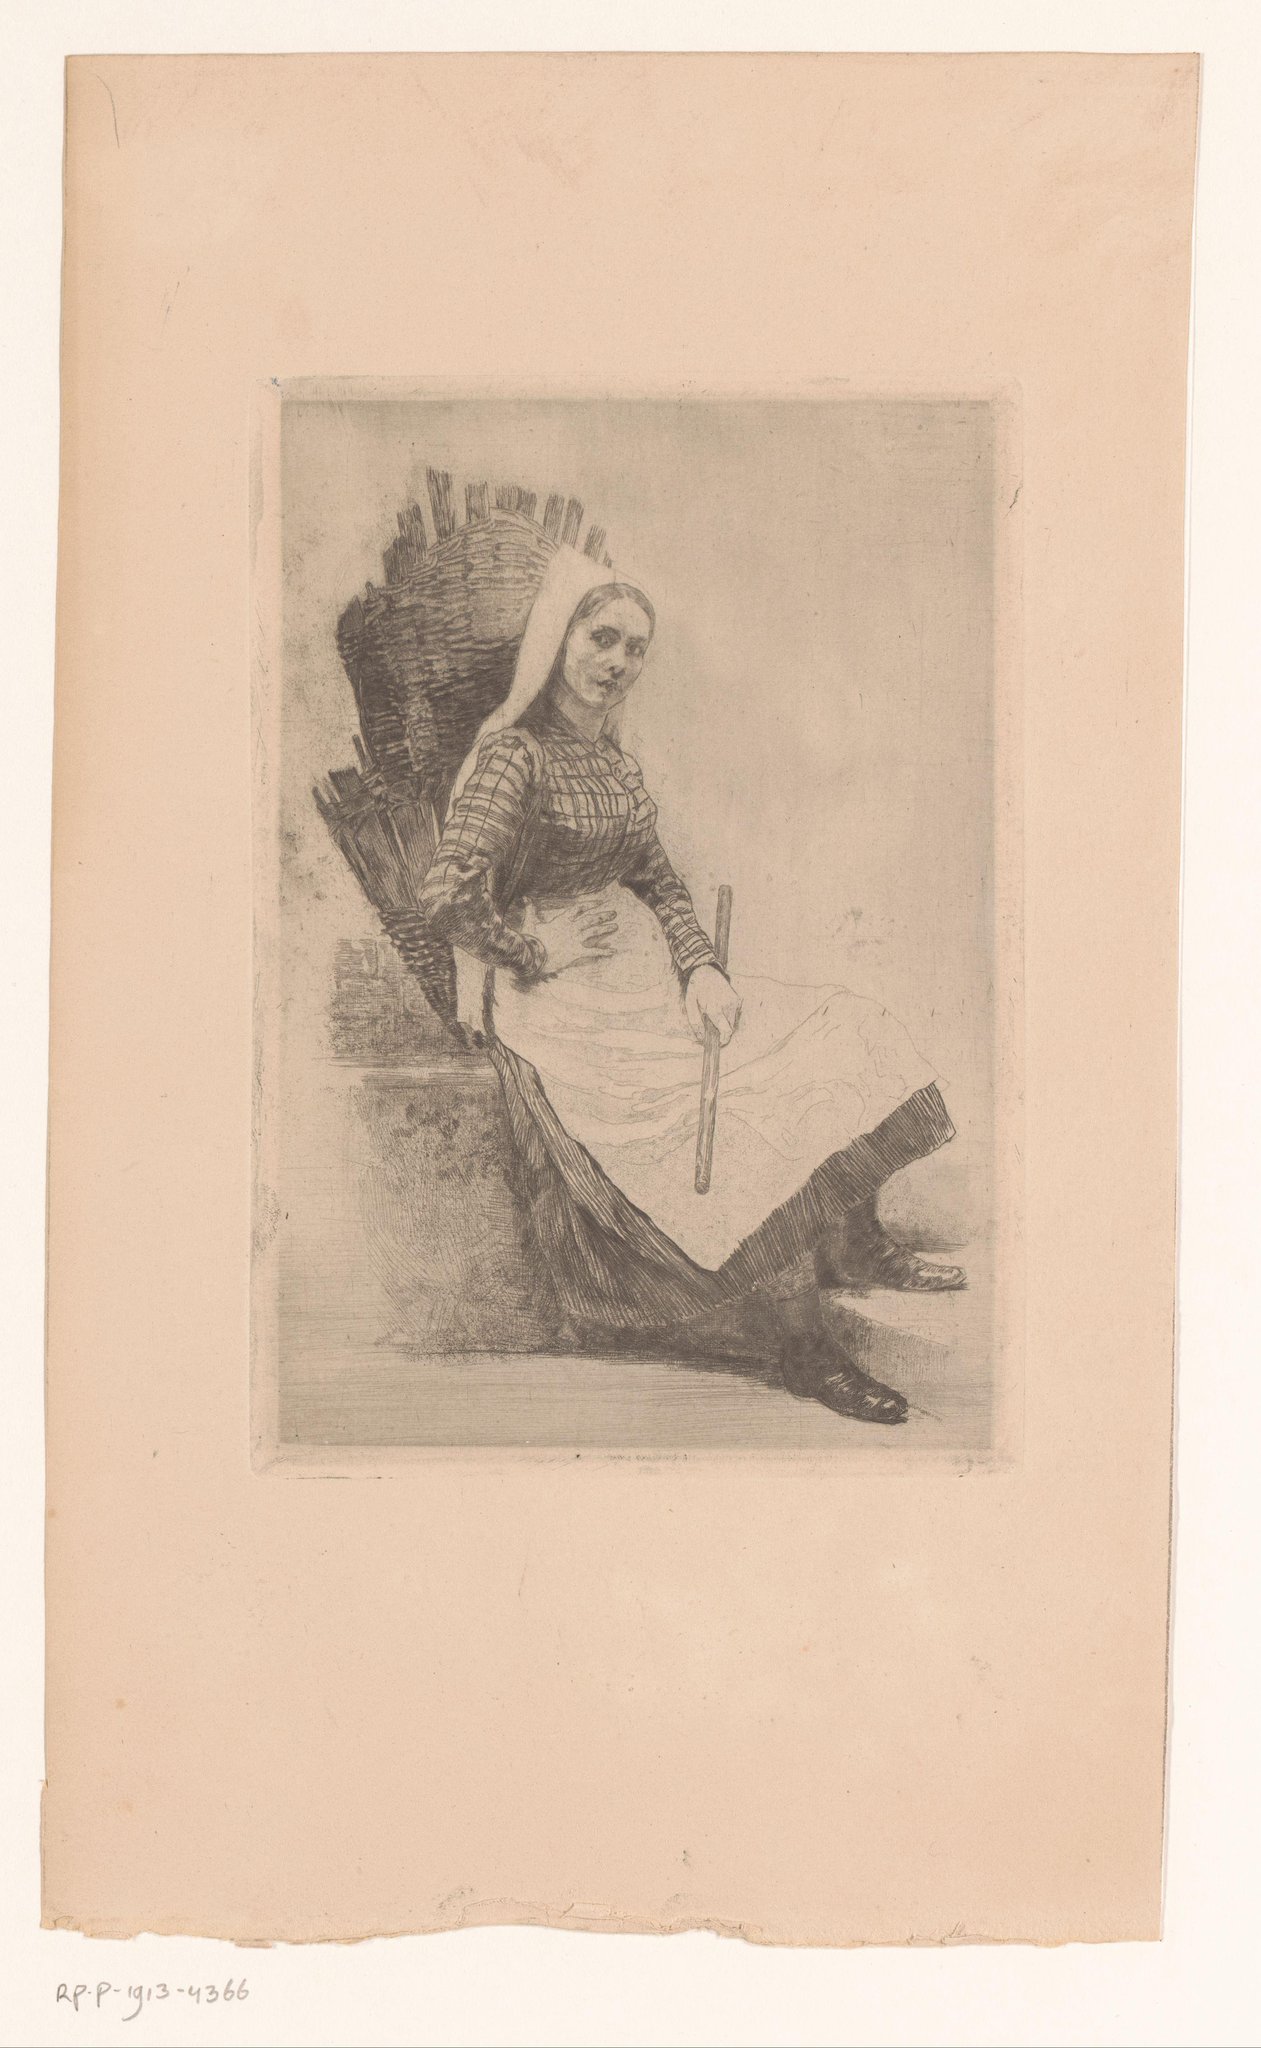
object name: print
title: Vrouw met mand op haar rug en een stok in haar hand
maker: adrien de witte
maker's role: print maker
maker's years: 1850-1935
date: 1890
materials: paper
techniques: drypoint, etching, intaglio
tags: adult woman, head-gear, container made of plant material other than wood: basket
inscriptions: collector's mark: Lugt 2228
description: Een dergelijke rieten mand werd ook wel gedragen door een zogenoemde 'botteresse'.